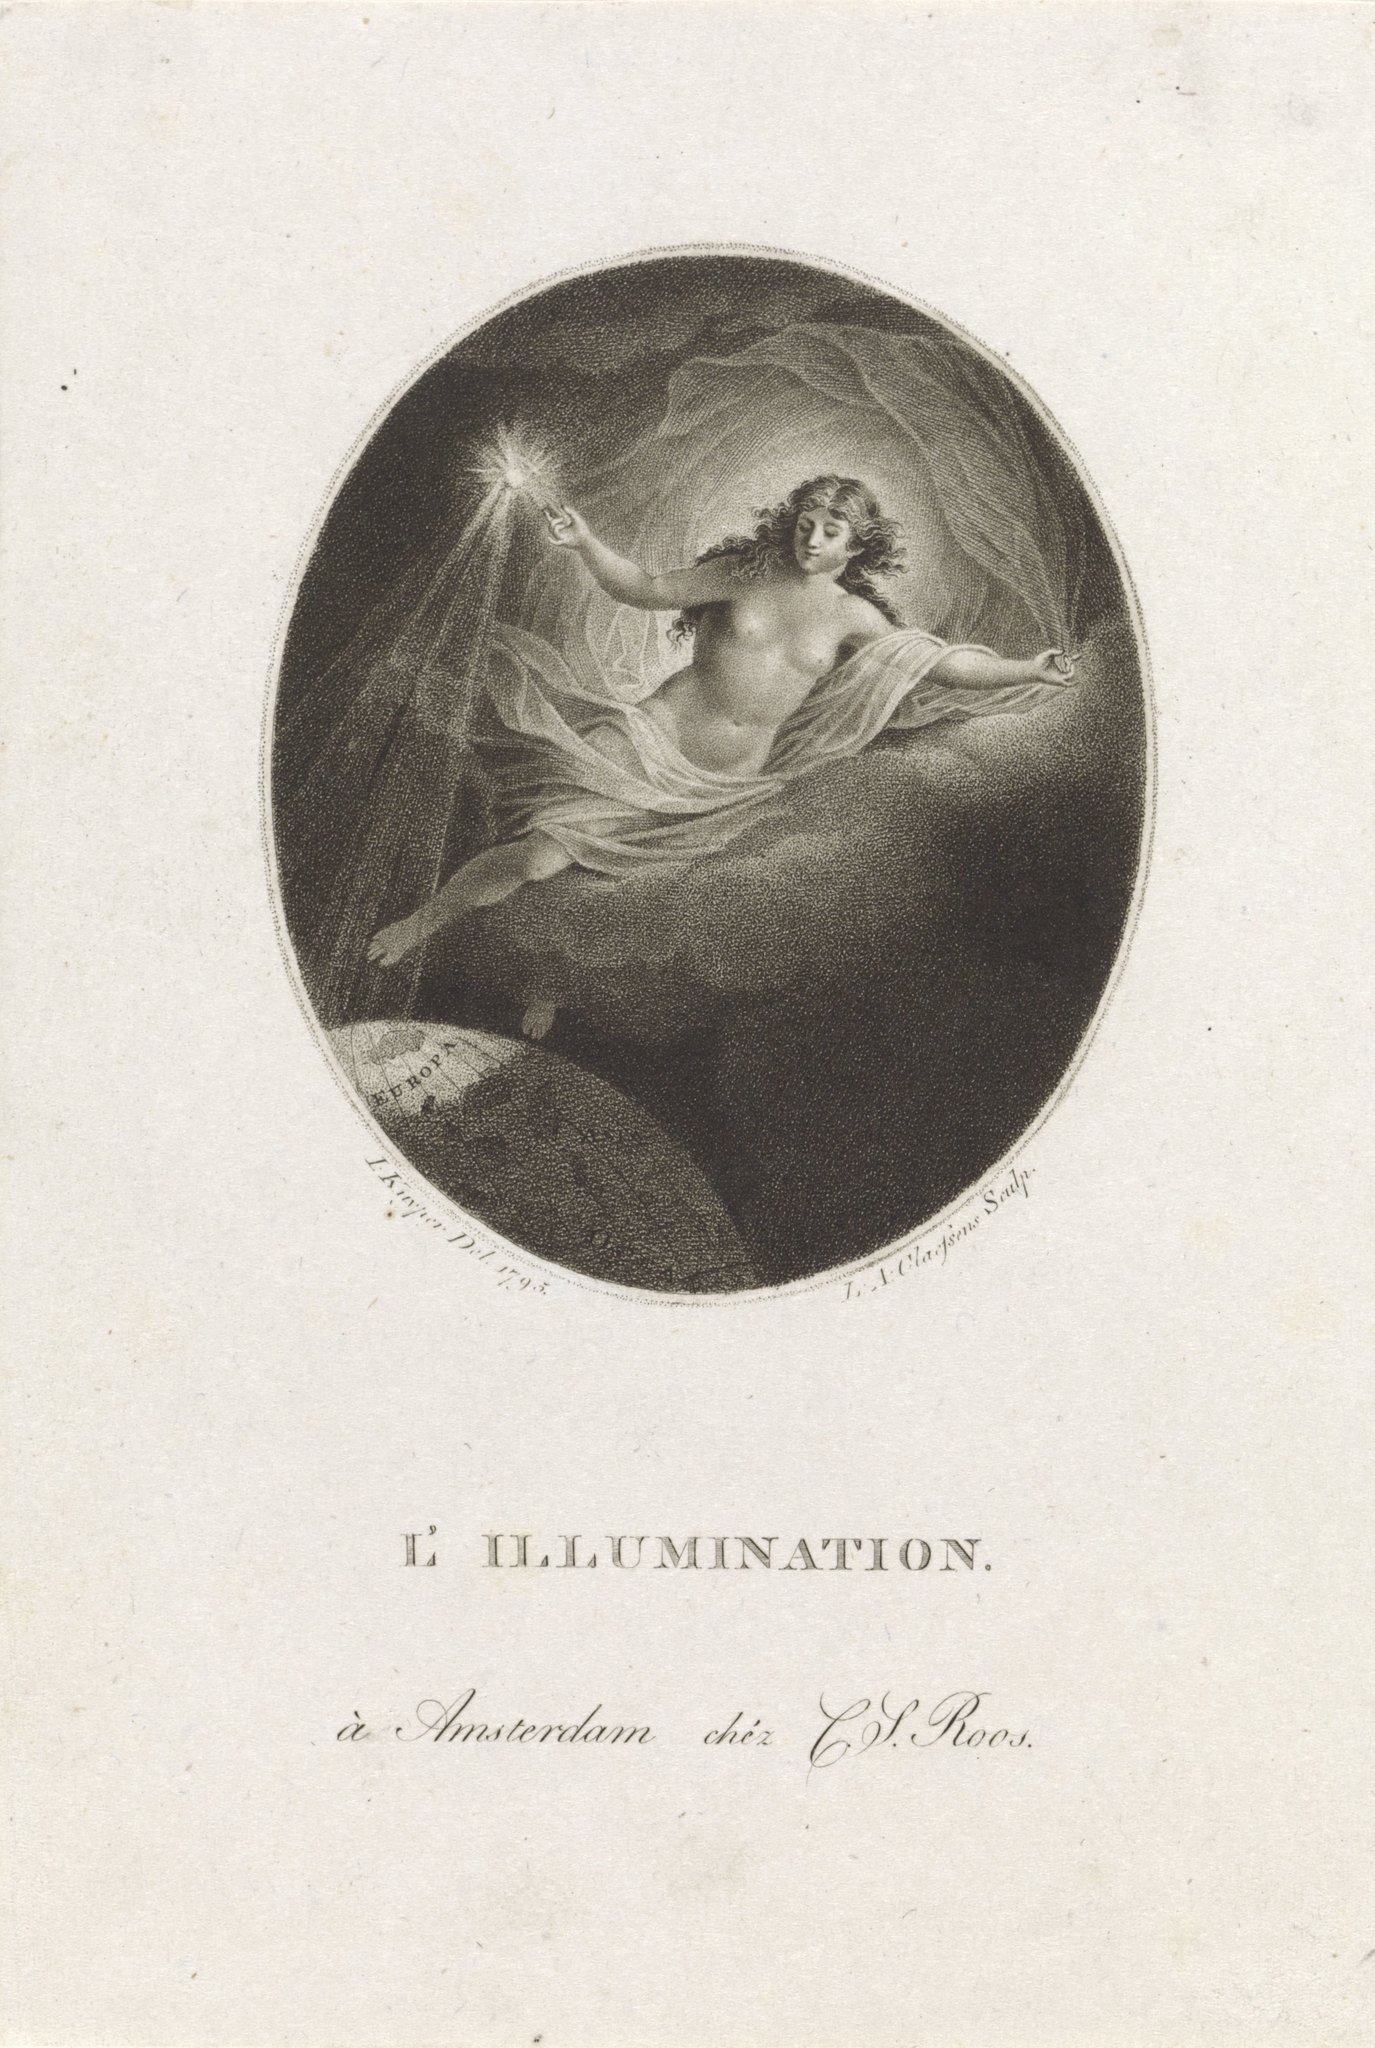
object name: print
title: Allegorie op de Verlichting, 1795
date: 1795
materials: paper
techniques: stippling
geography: amsterdam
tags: light shining out of the heavens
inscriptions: collector's mark: Lugt 2228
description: Allegorie op de Verlichting, 1795. De vrouwelijke personificatie van de Verlichting zweeft boven de wereld en laat haar licht op Europa schijnen.